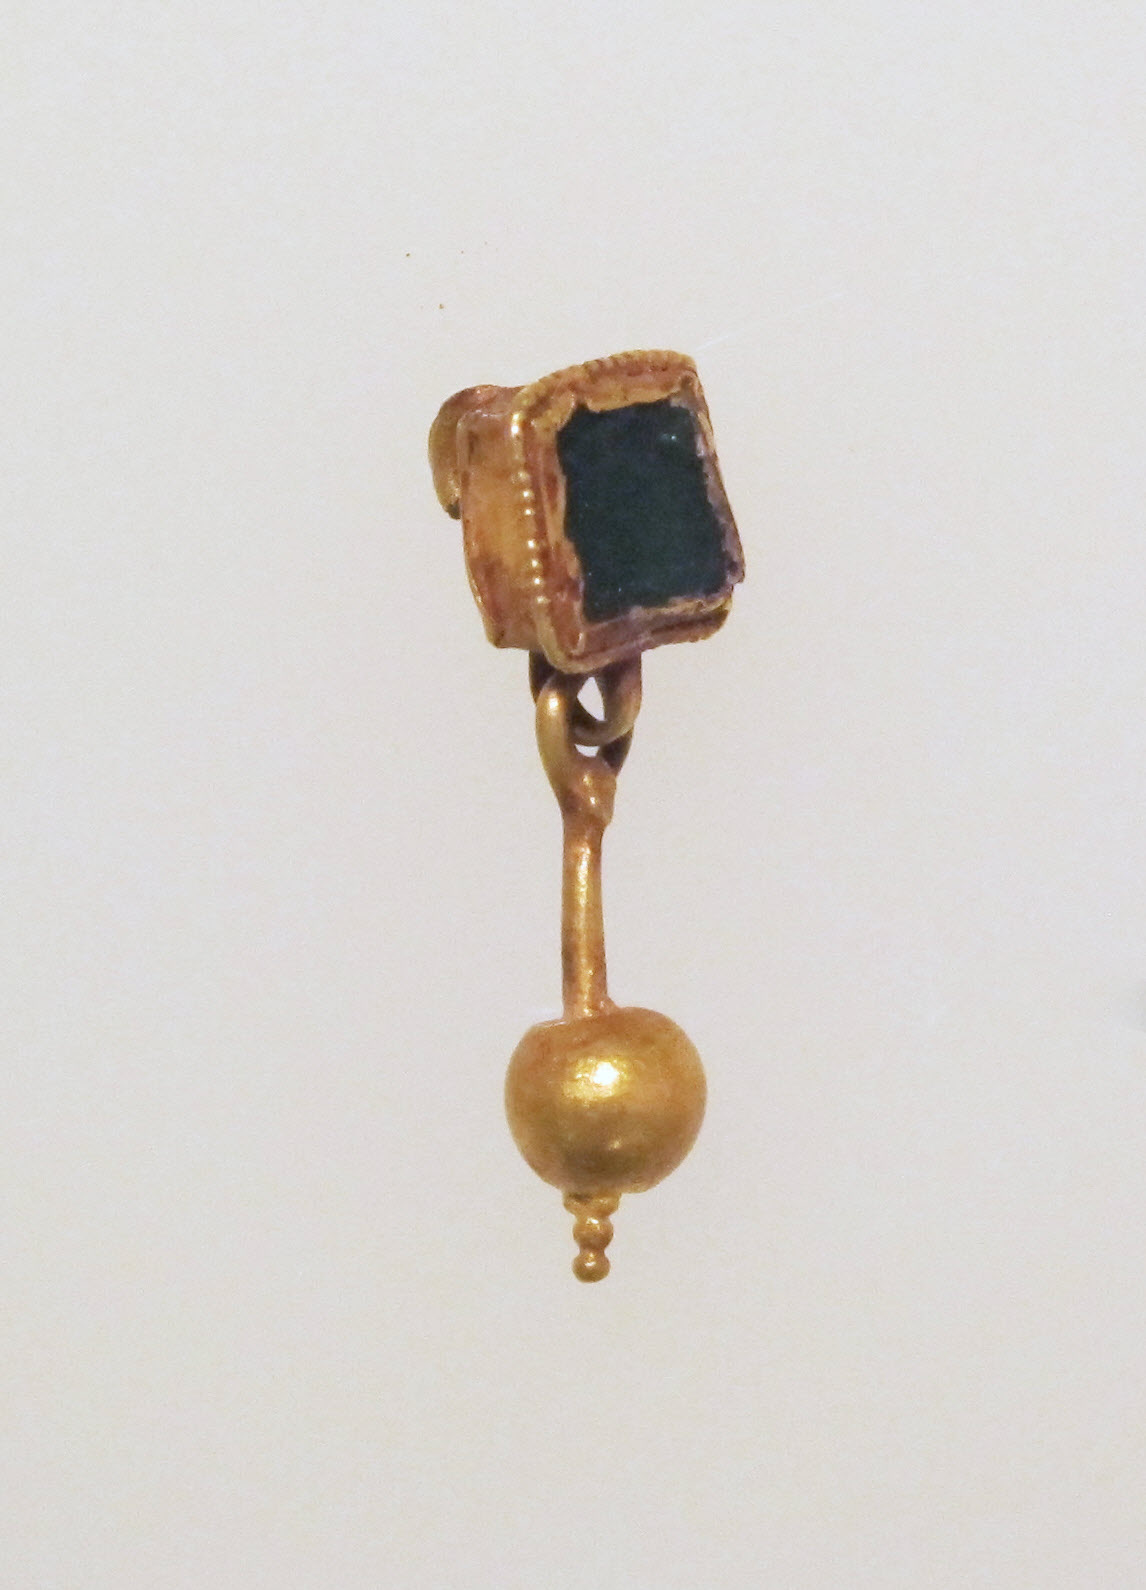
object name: earring hook type with ball pendant and paste setting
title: Earring-hook type with ball pendant and paste setting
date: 7000 BCE-330 CE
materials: glass, gold, paste